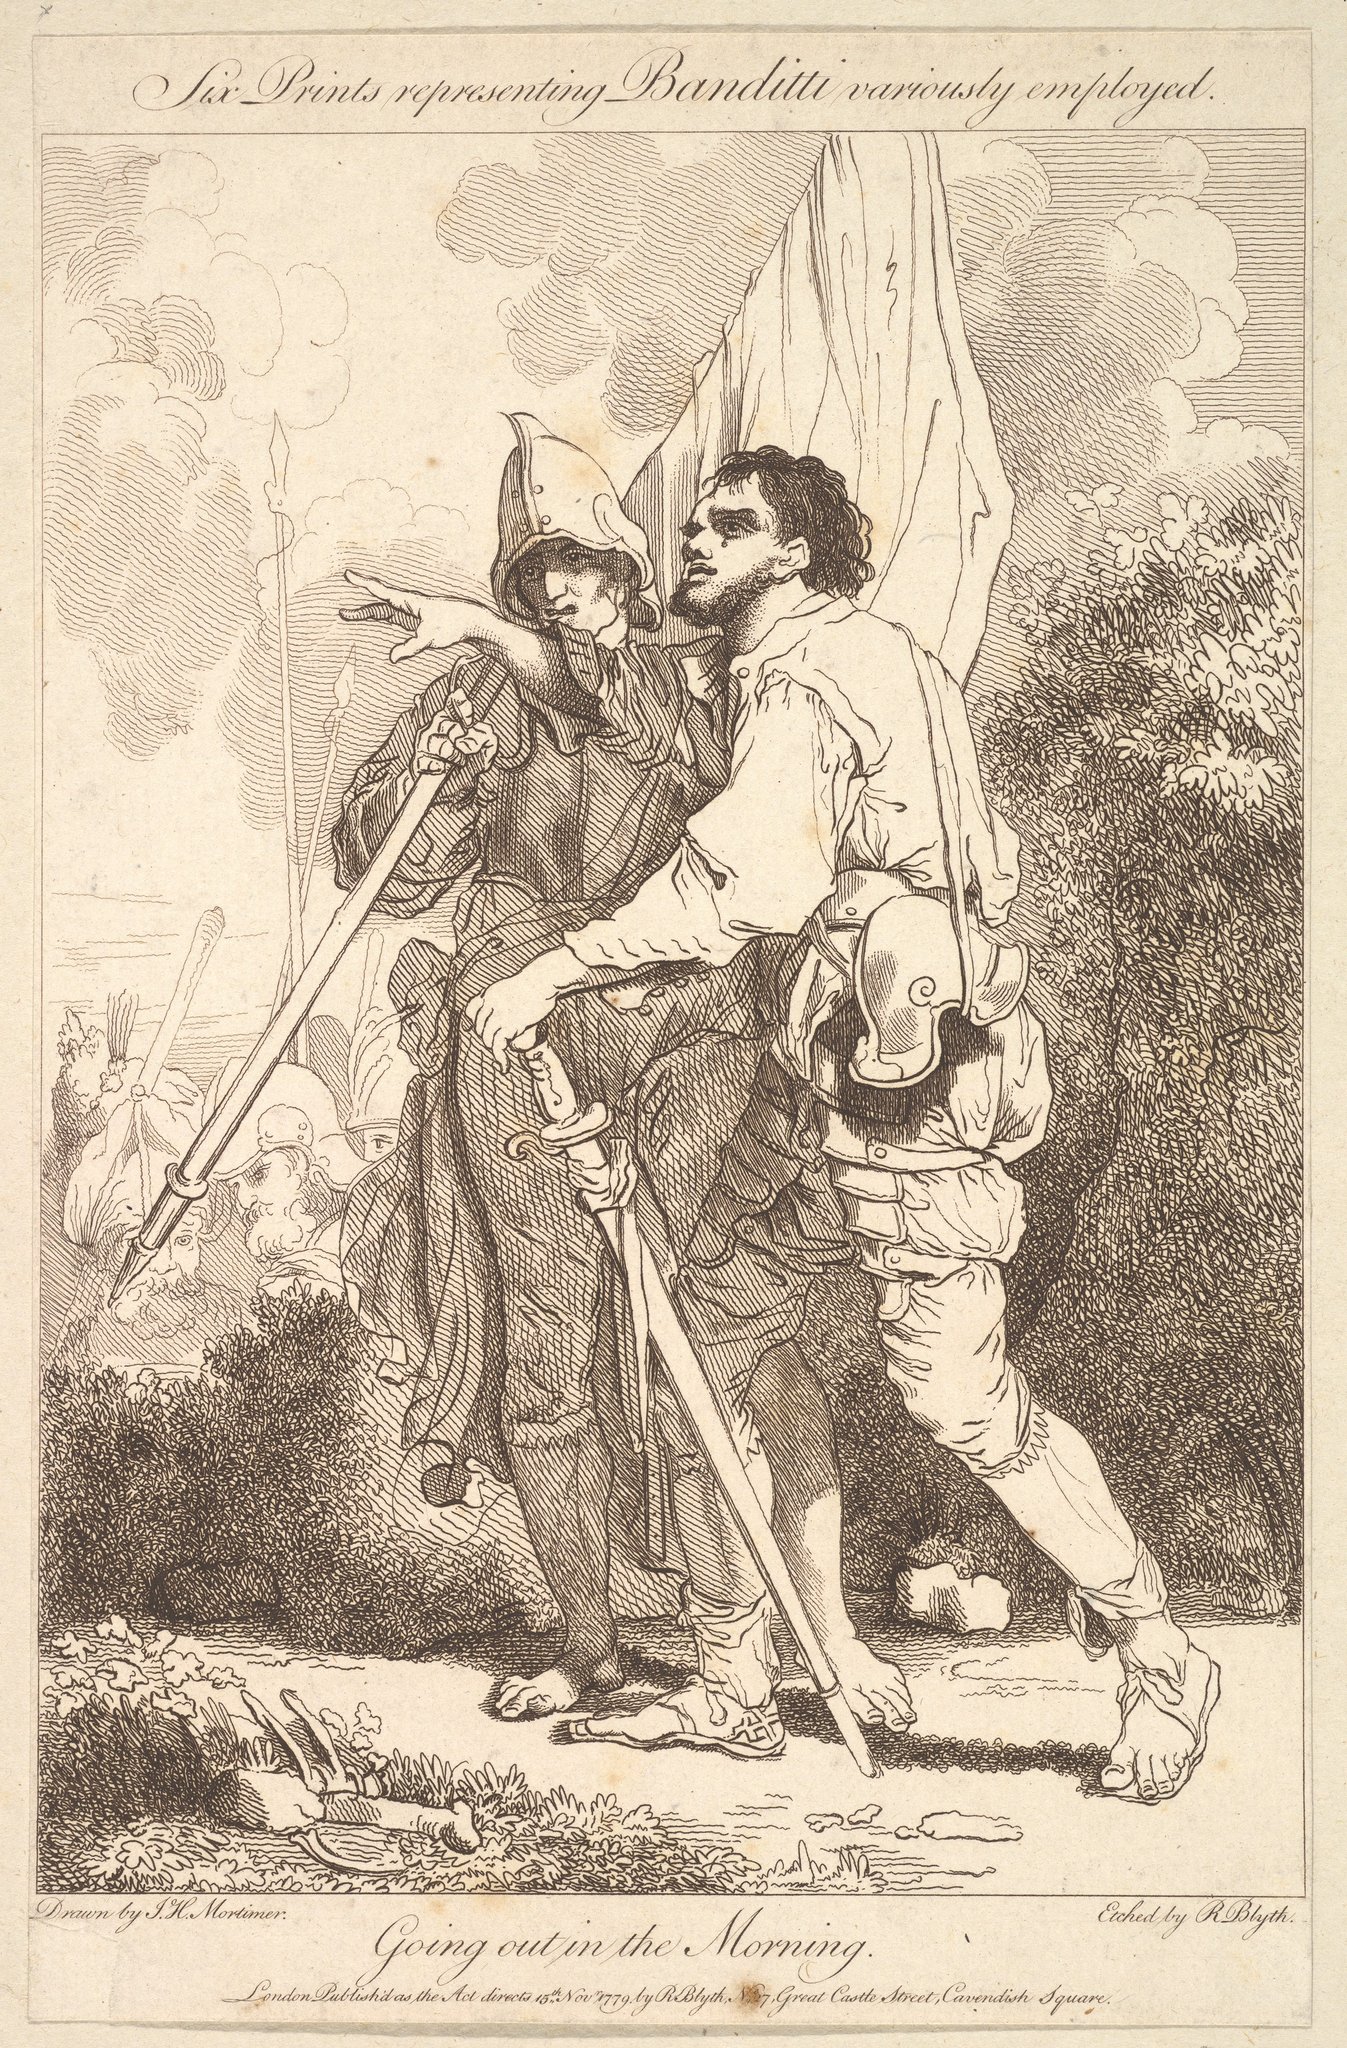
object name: print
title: Going Out in the Morning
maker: robert blyth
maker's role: artist and publisher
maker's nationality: british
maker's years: 1750-1784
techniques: etching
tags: swords,men,morning,flags